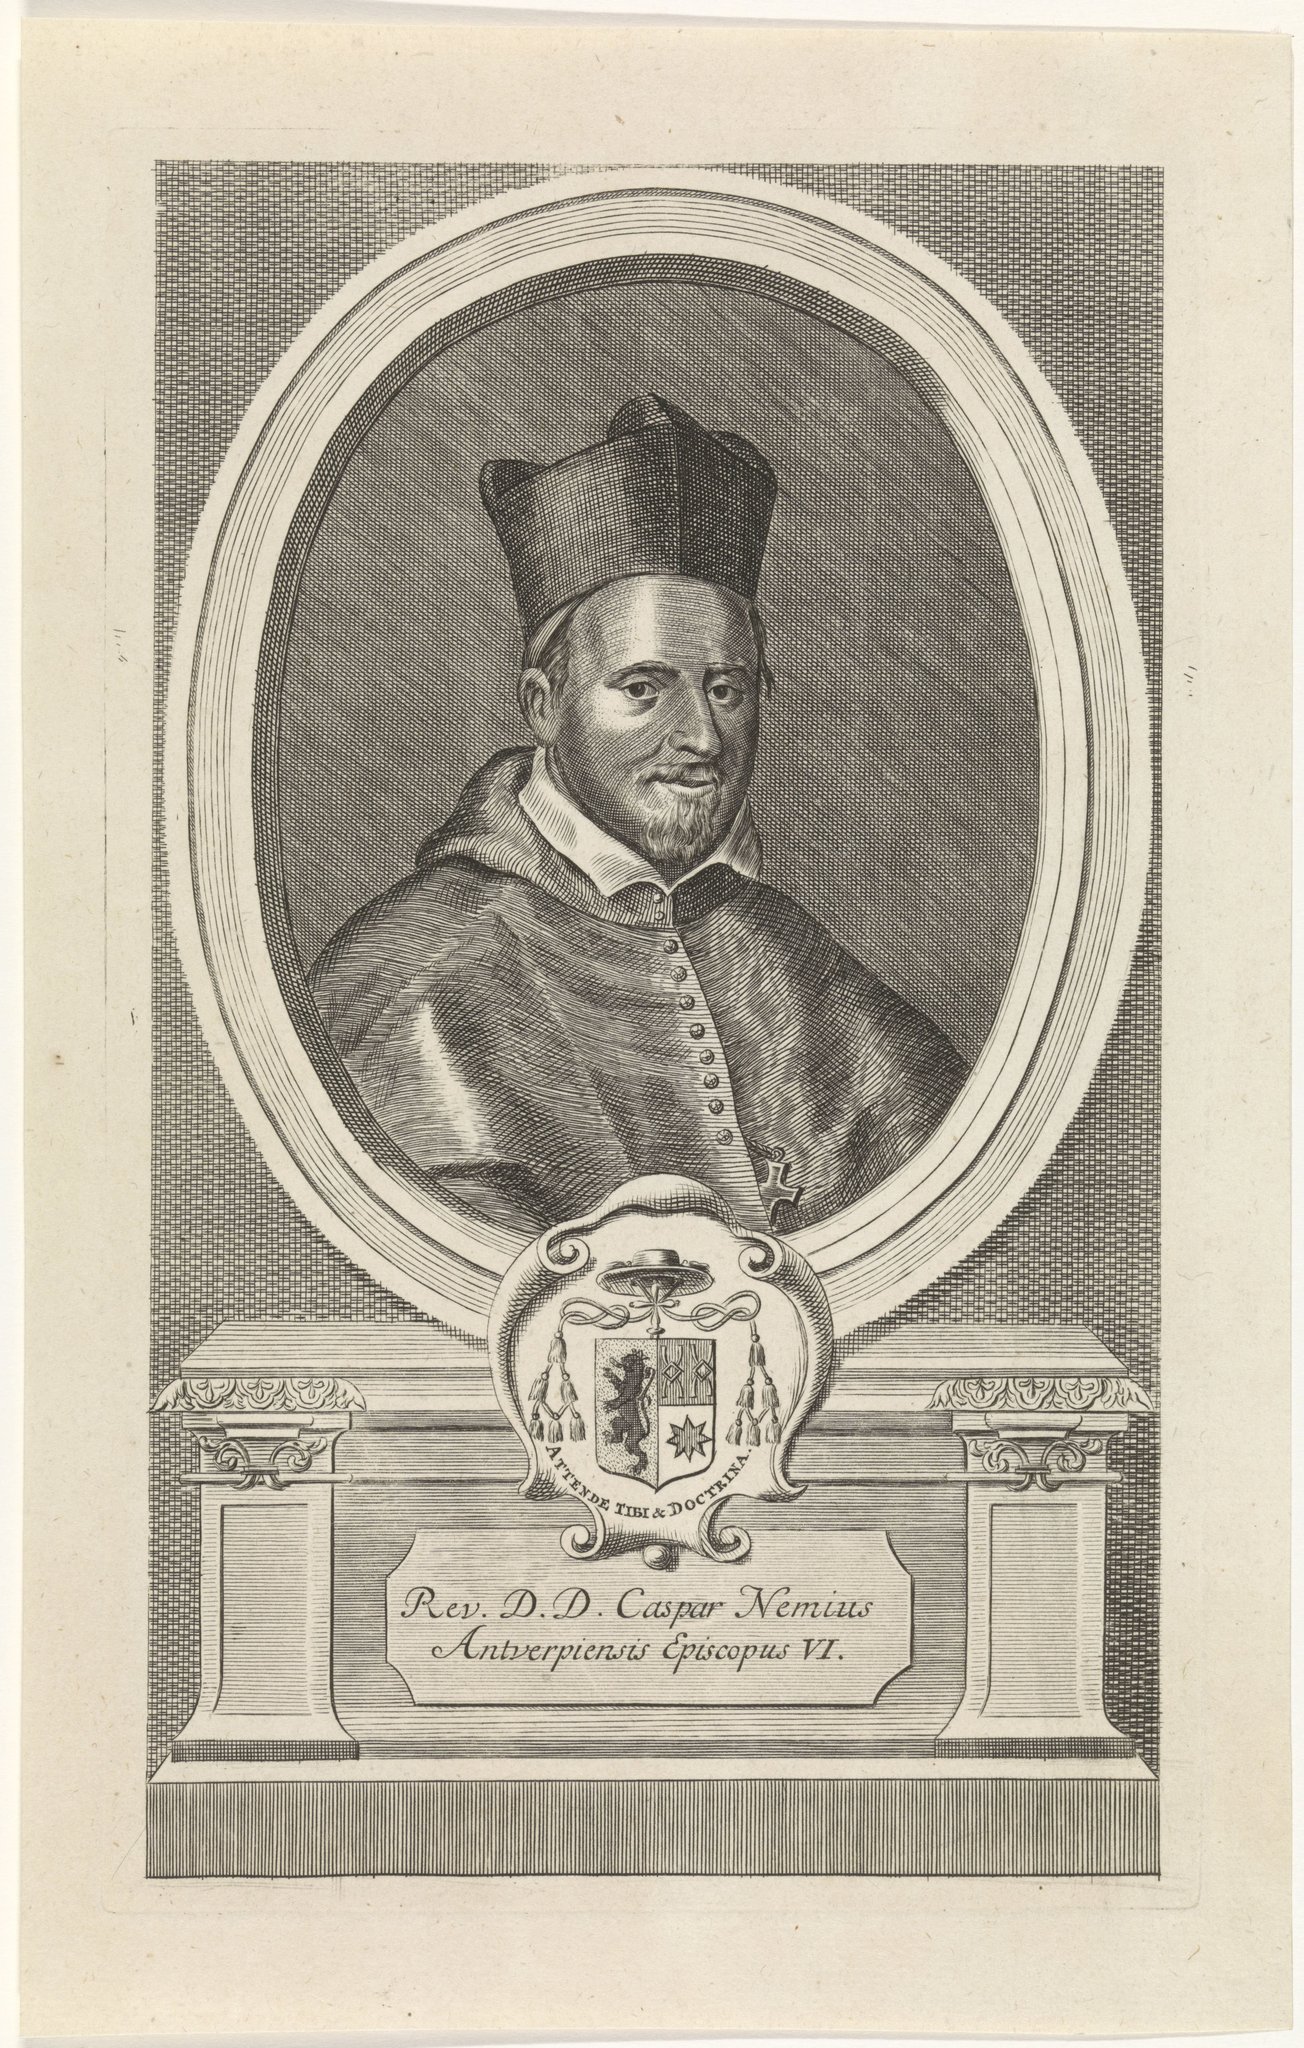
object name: book illustration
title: Portret van Gaspar Nemius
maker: jan baptist jongelinx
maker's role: print maker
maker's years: 1689-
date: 1710-1725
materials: paper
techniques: engraving, etching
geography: antwerp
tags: gaspar nemius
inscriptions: collector's mark: Lugt 2228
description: Busteportret van de bisschop Gaspar Nemius, met biretta. Het portret is gevat in een ovale omlijsting met het wapenschild van de geportretteerde en een motto in het Latijn. In een kader een tweeregelig onderschrift in het Latijn.